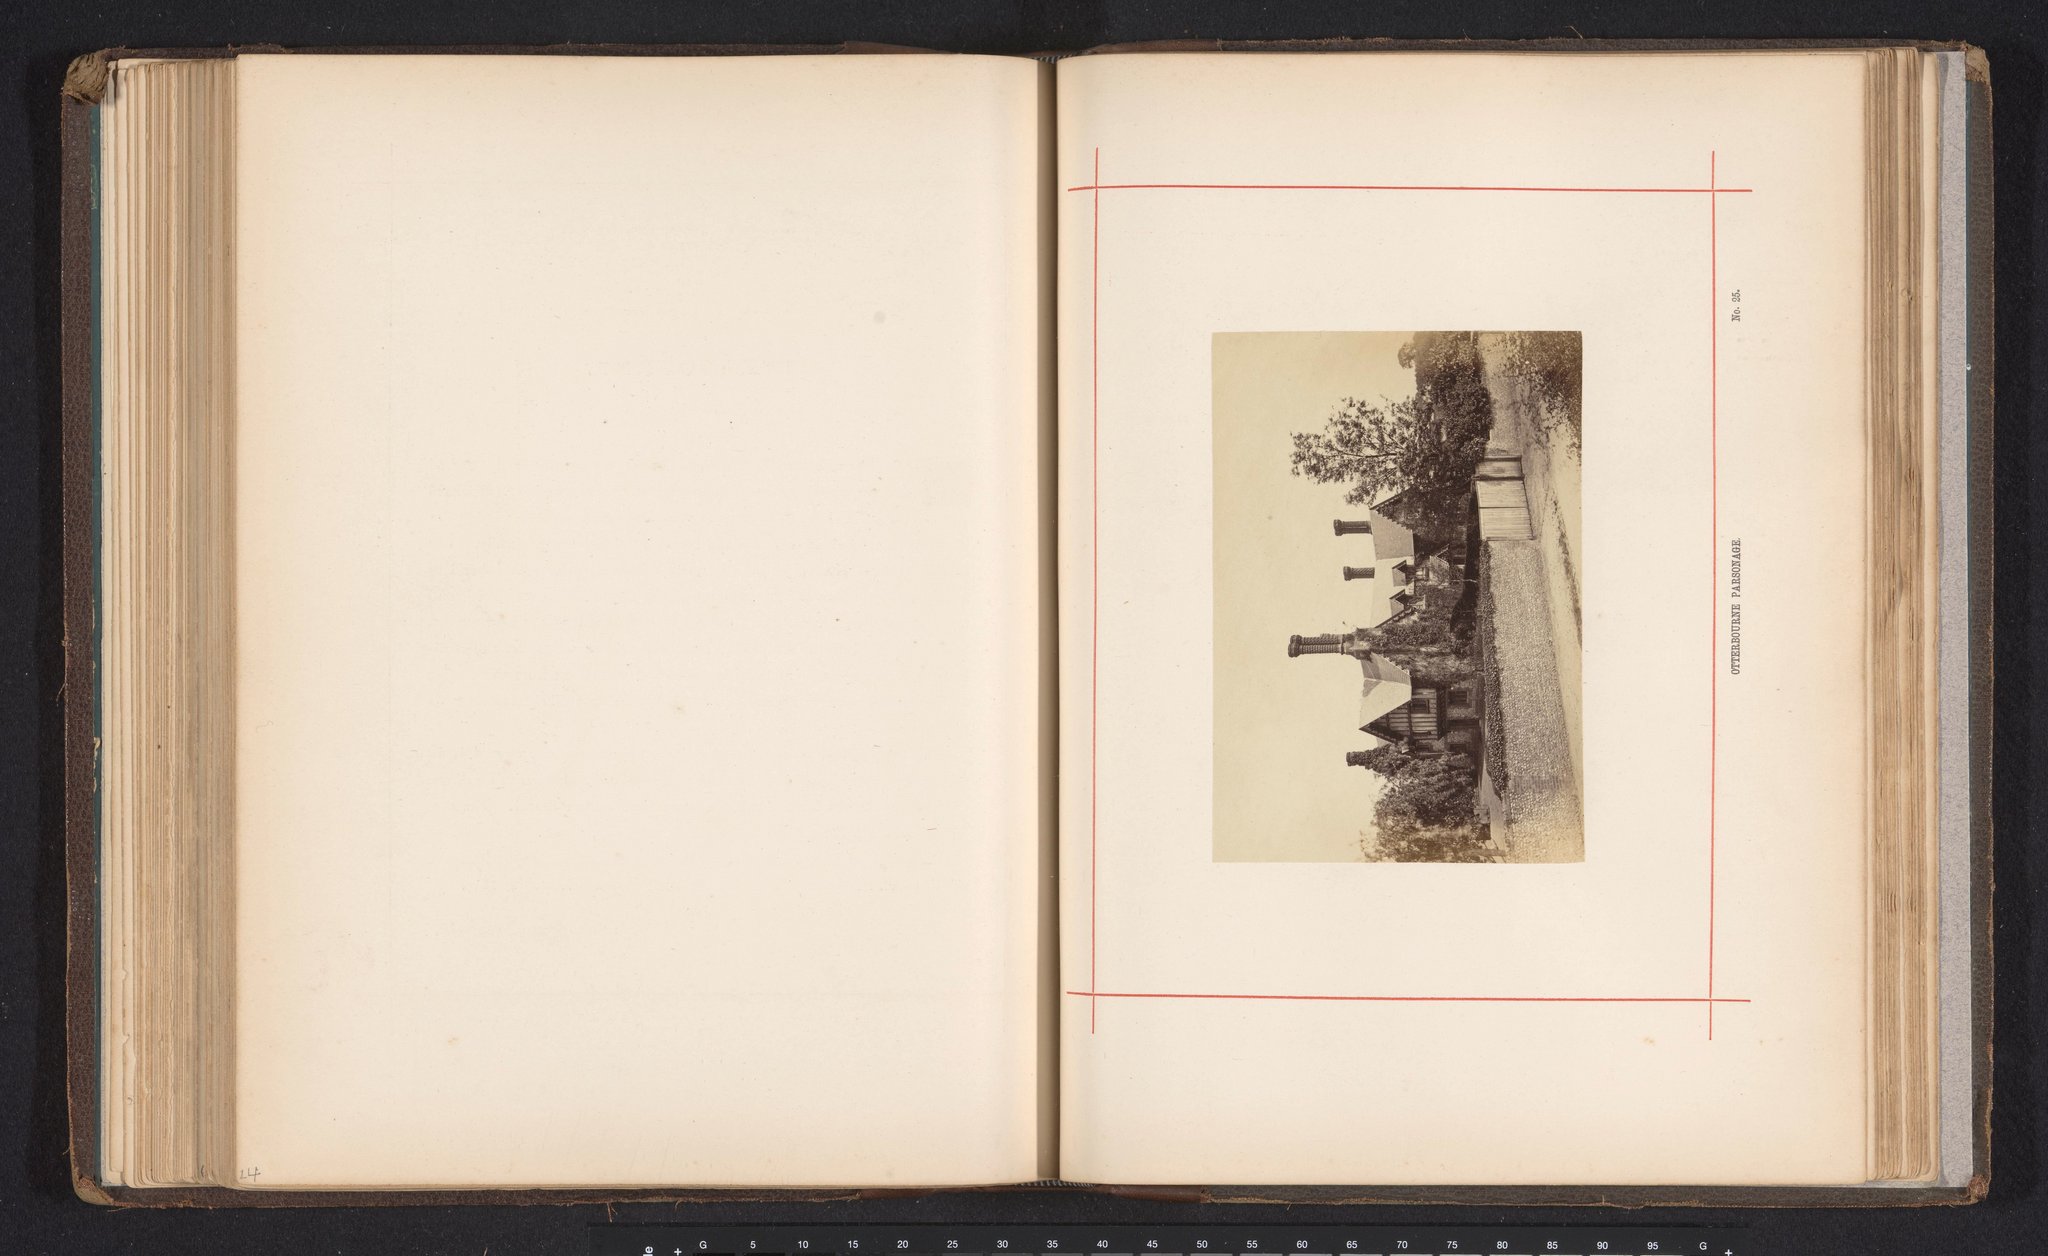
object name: page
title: Otterbourne Parsonage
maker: william savage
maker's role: fotograaf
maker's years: 1817-1887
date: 1856-1866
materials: photographic support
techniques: albumen print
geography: otterbourne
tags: housing, organization, functionaries and dignitaries in roman catholic church; clergy in general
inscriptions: number: ‘No. 25.’